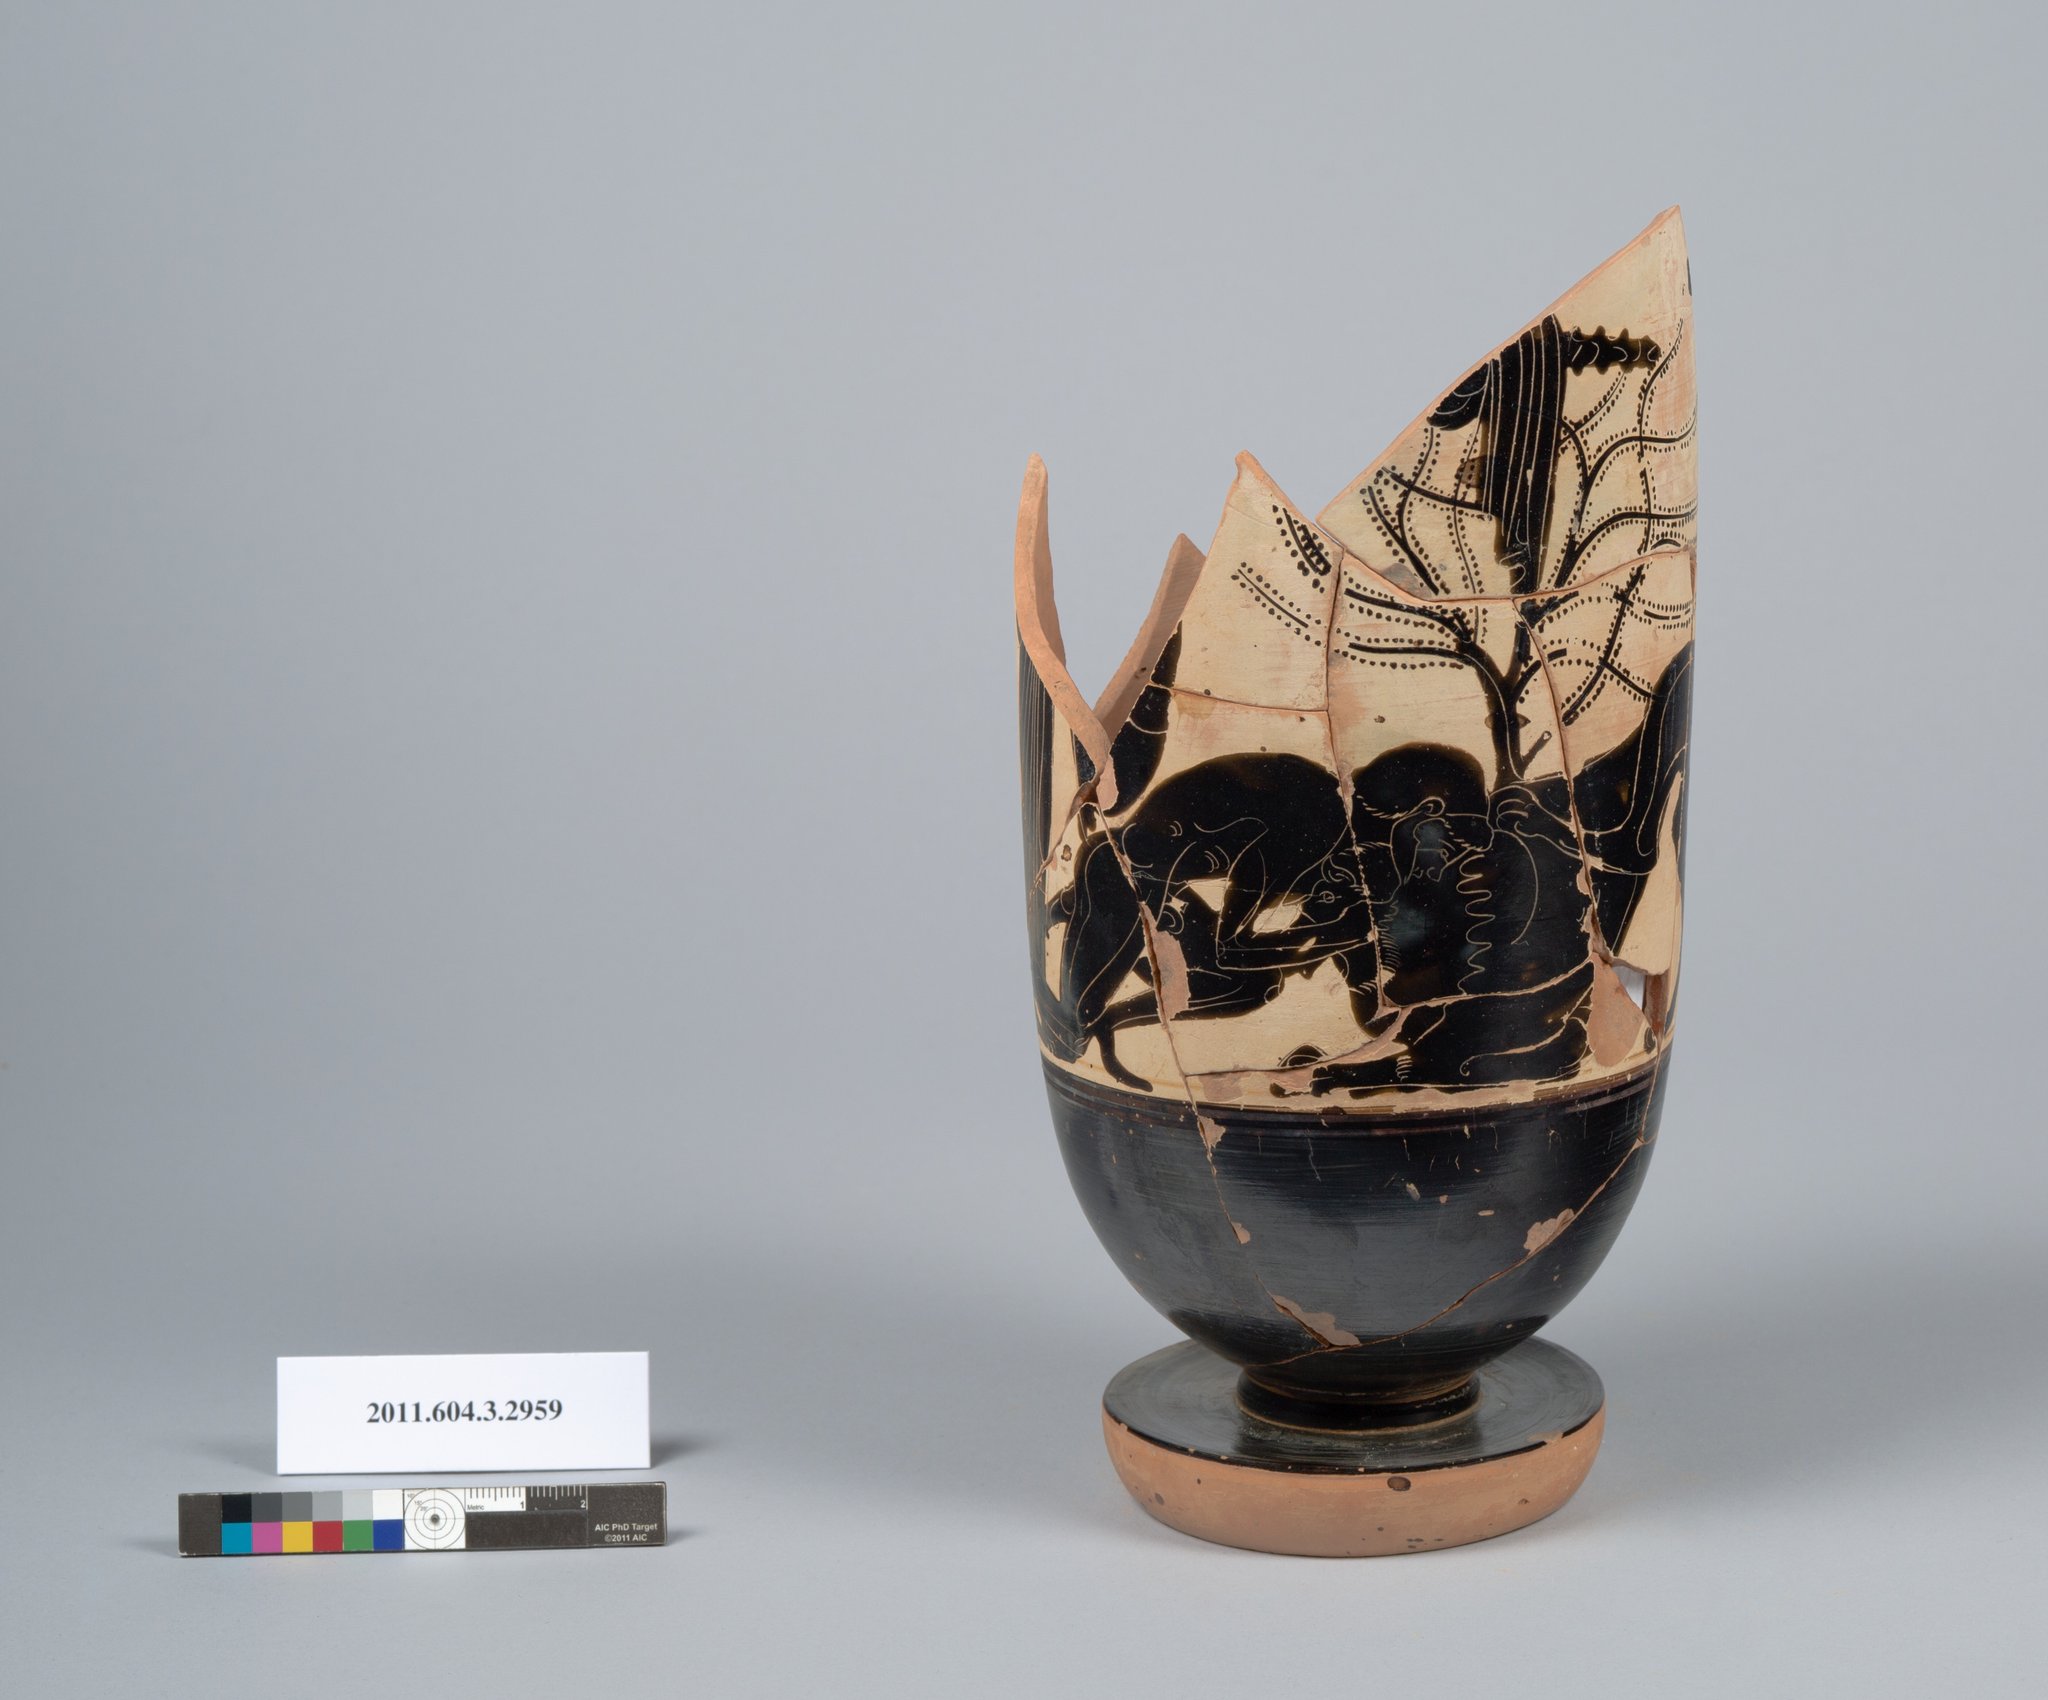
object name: lekythos fragment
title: Terracotta fragment of a lekythos (oil flask)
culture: greek, attic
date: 534-501 BCE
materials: terracotta